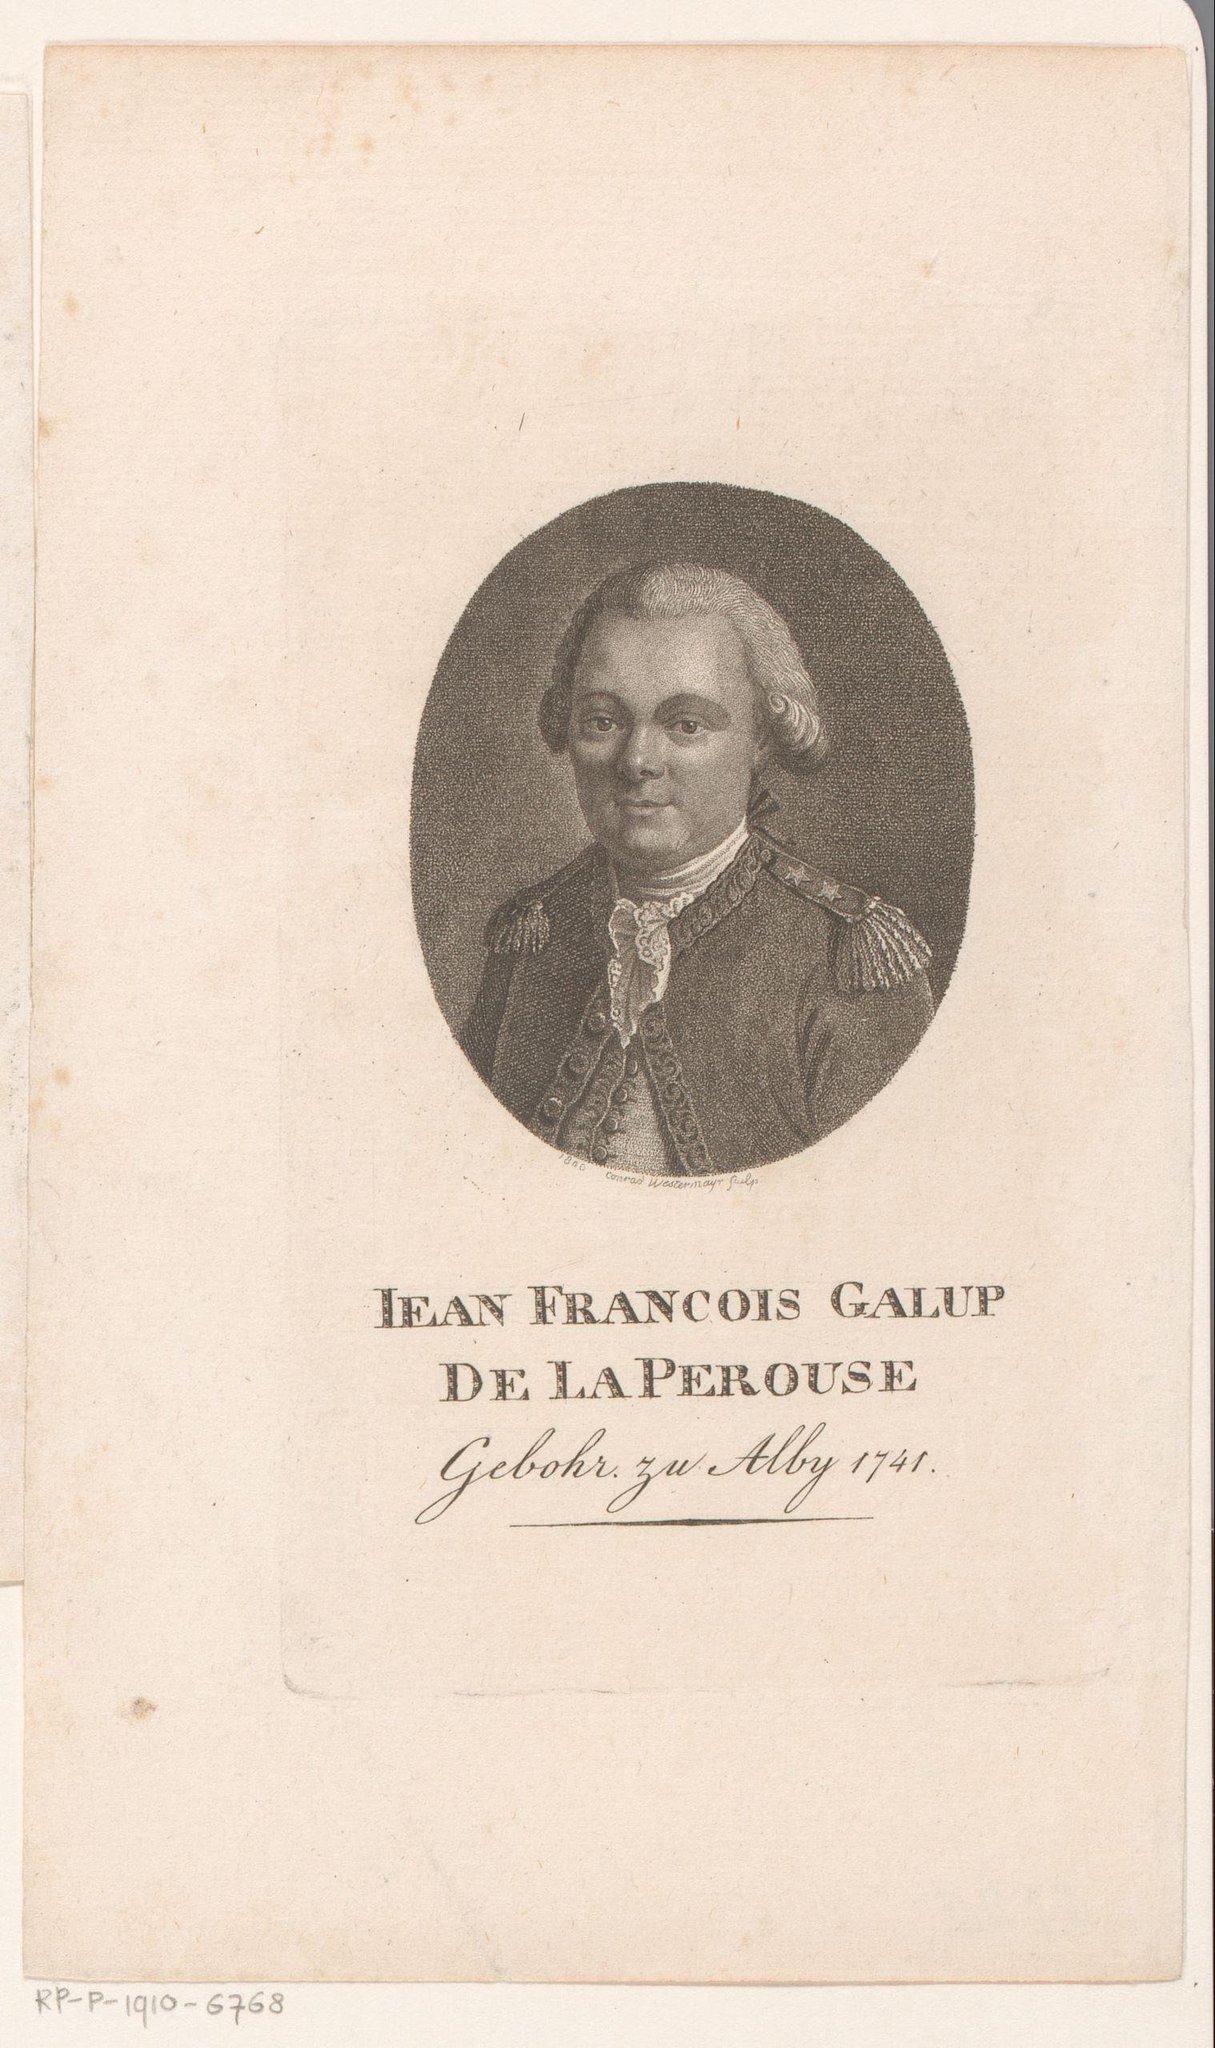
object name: print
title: Portret van Jean-François de La Pérouse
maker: konrad westermayr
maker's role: print maker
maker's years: 1765-1834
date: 1800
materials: paper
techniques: engraving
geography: germany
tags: historical persons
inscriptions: collector's mark: Lugt 2228